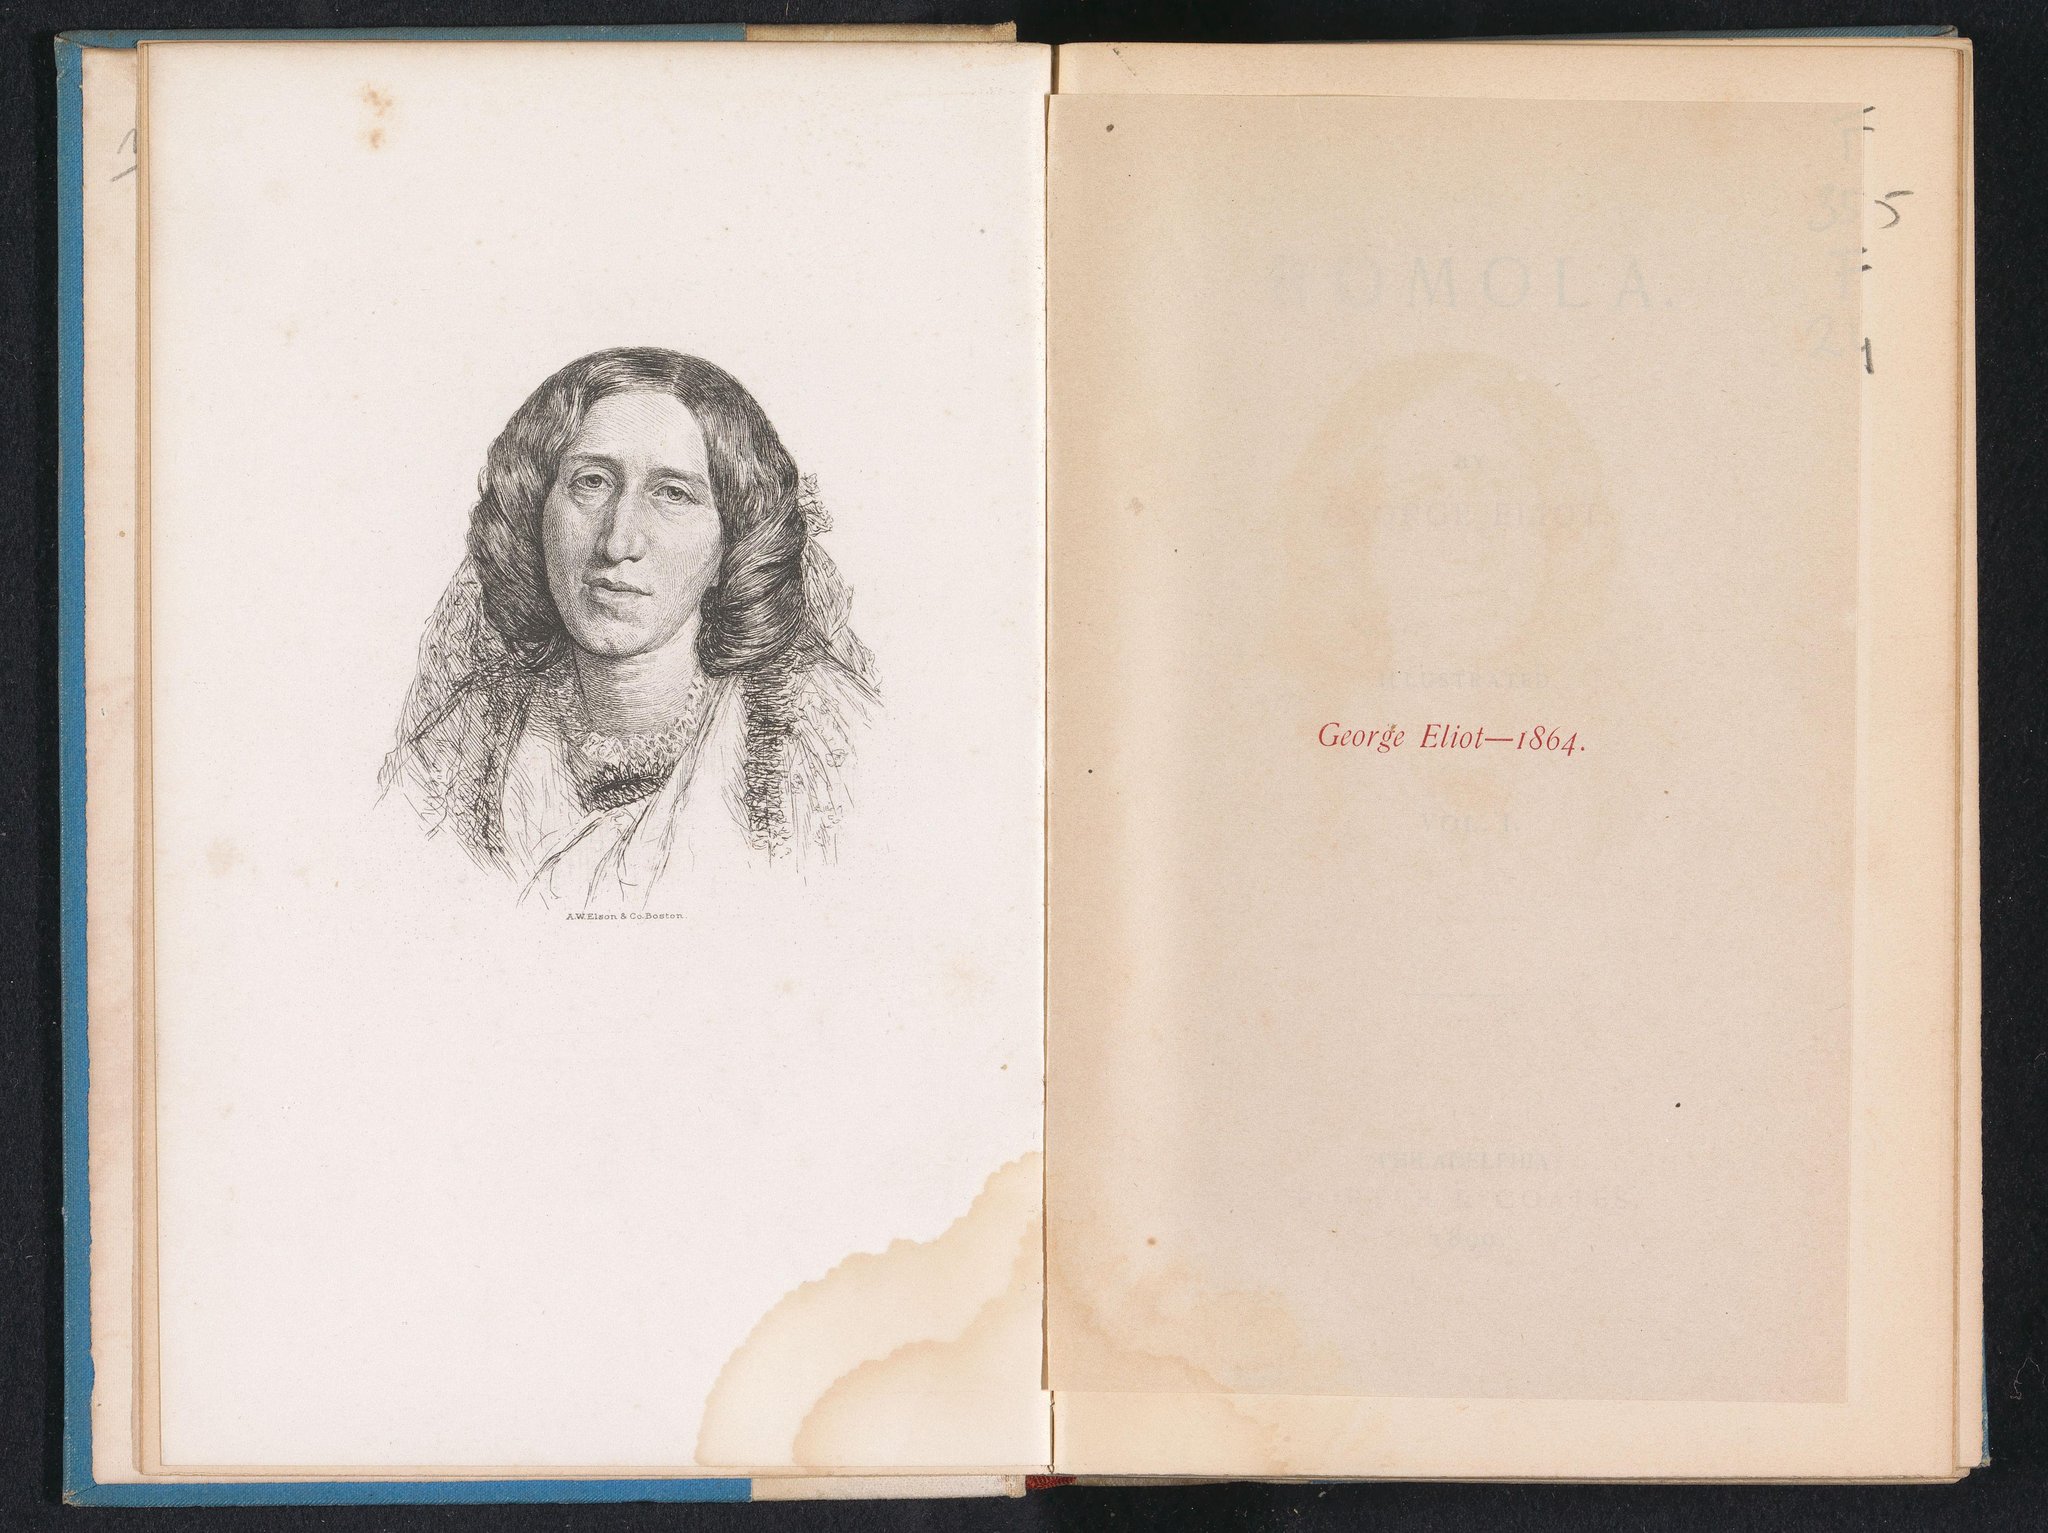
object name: page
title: Fotoreproductie van een prent, voorstellende een portret van George Eliot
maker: Anonymous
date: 1880-1890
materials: paper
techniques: photoaquatint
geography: boston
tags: george eliot, portrait of a writer